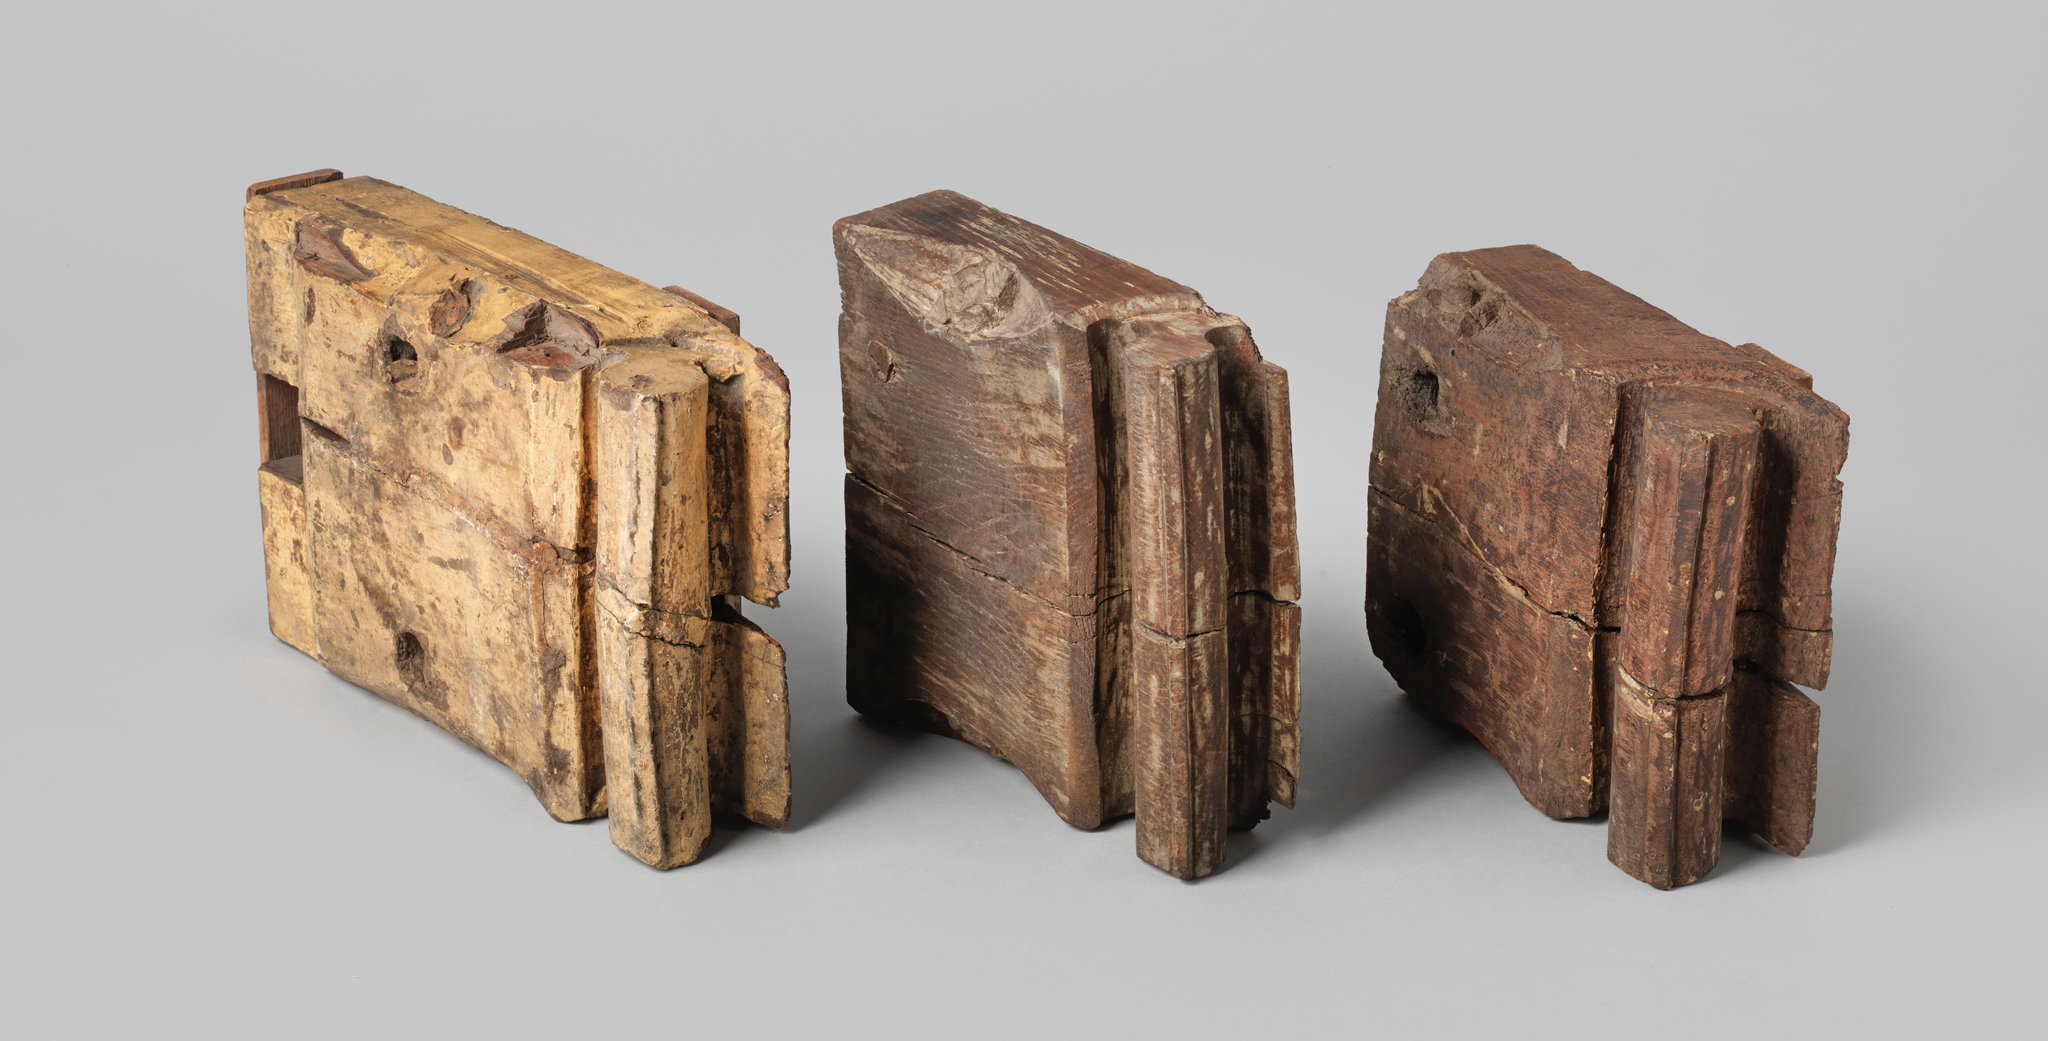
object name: architectural element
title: Bouwfragment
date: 1400-1950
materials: wood, paint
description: Een balksleutel van eikenhout met aan weerszijden gesneden rozetten.